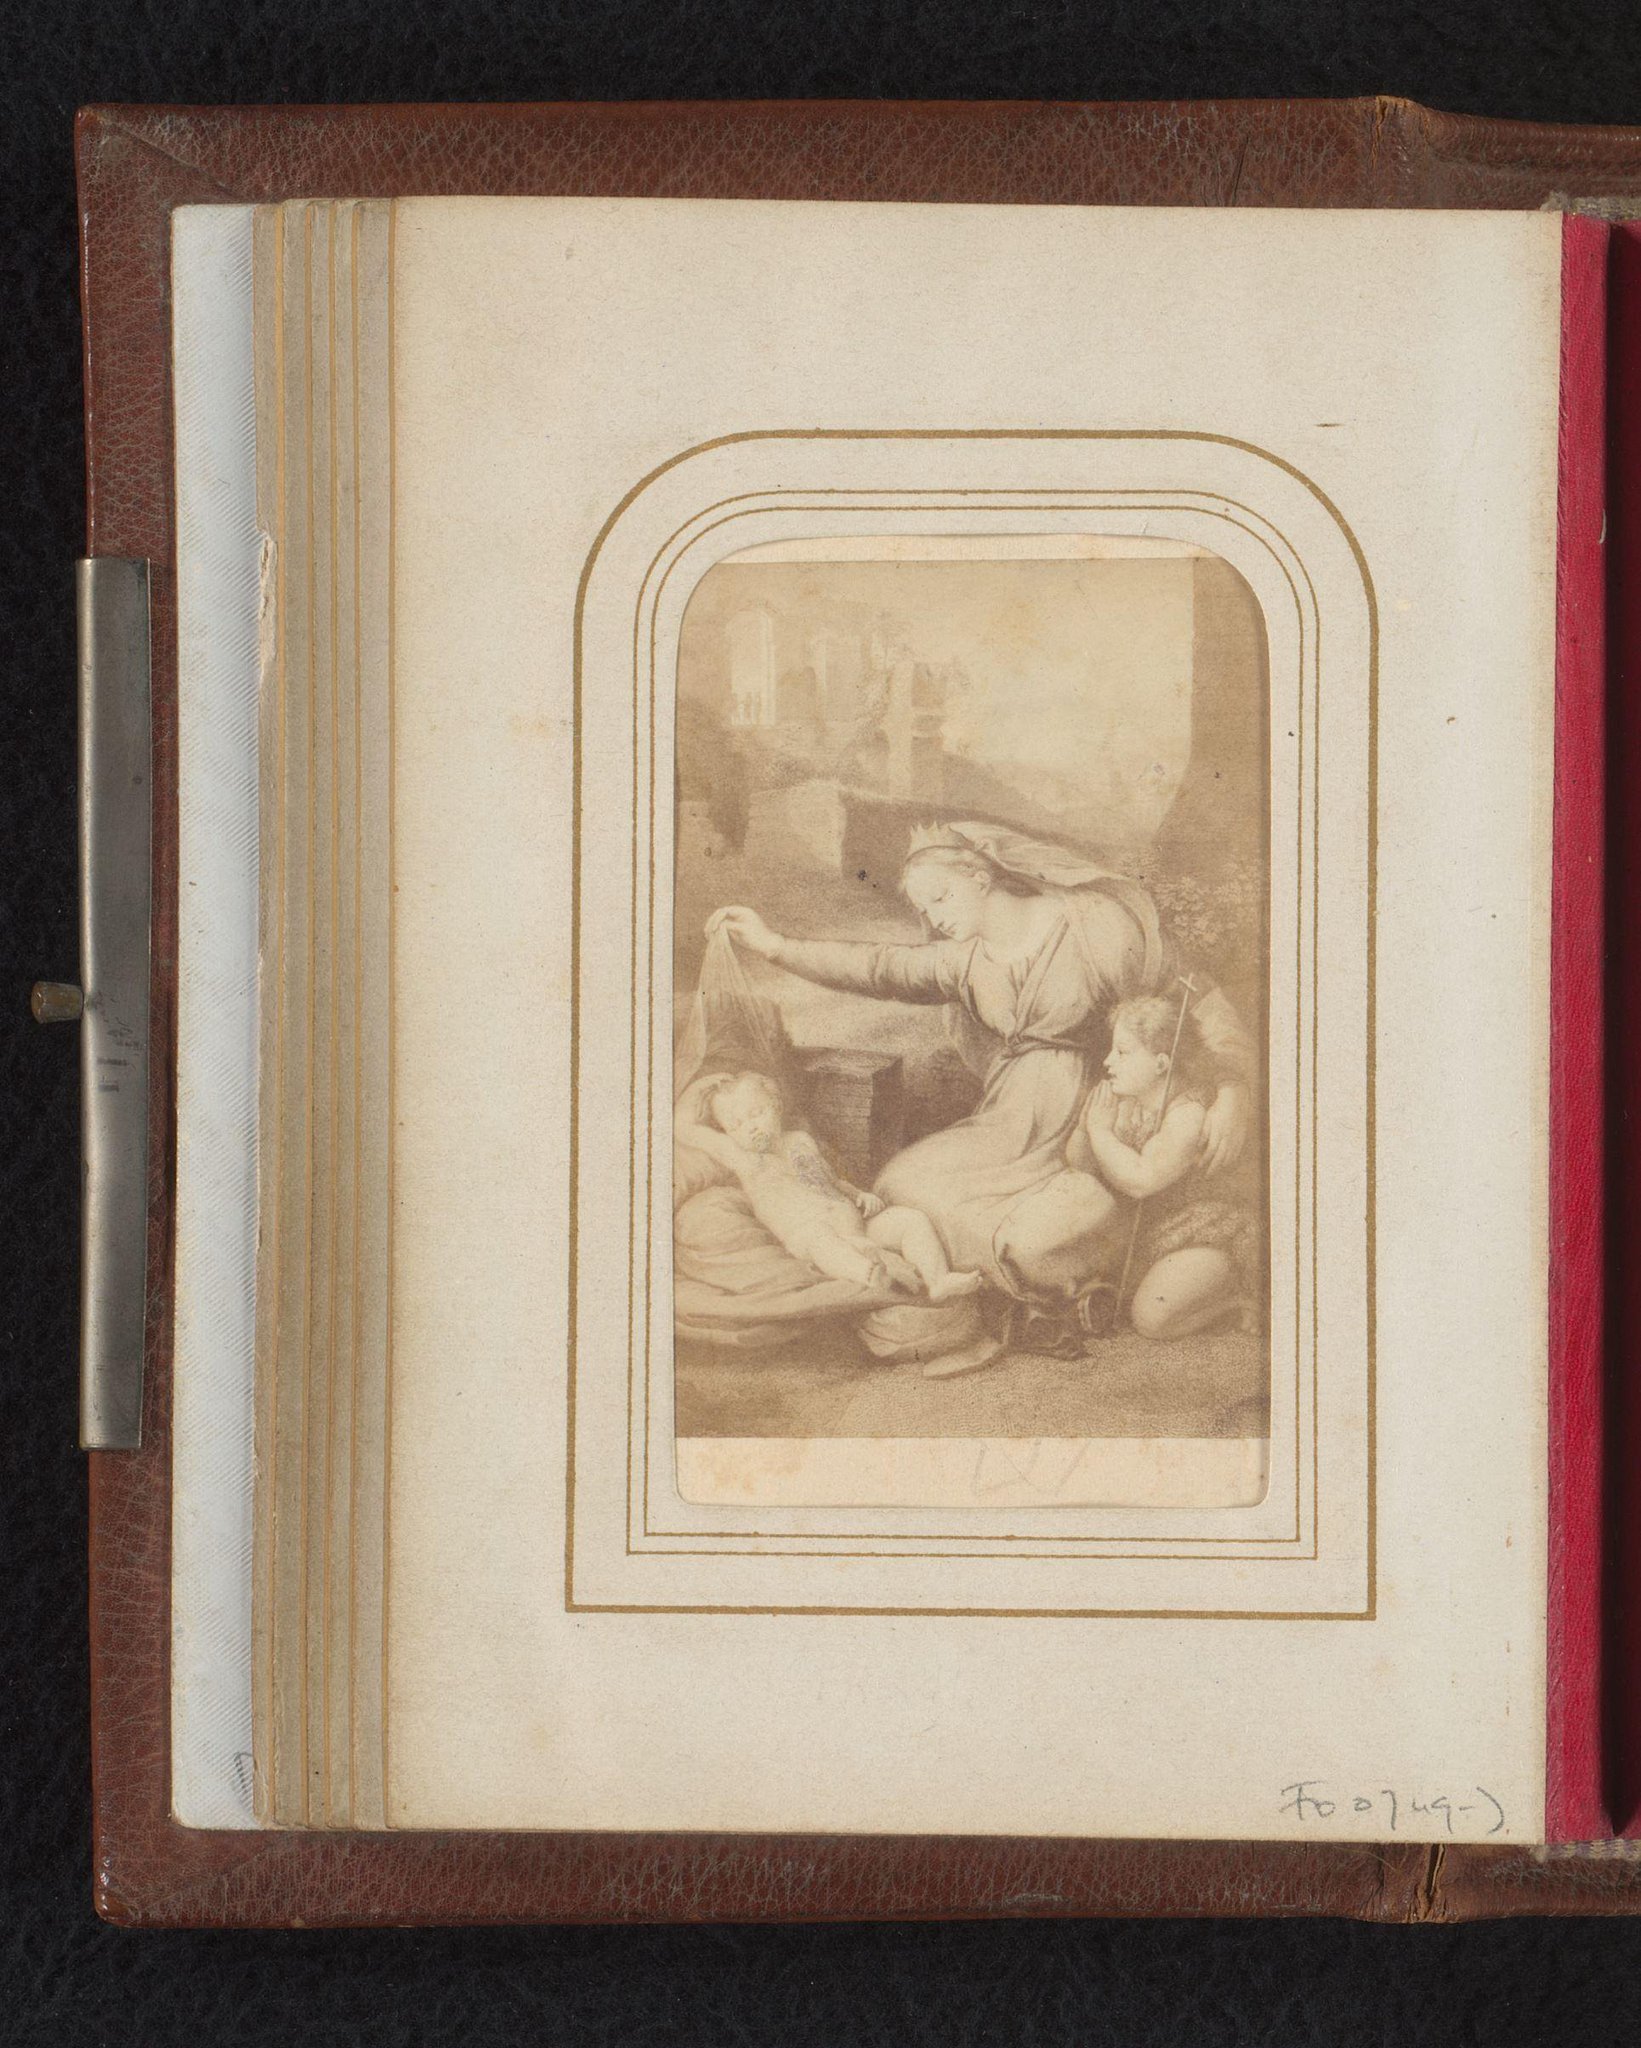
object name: reproduction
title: Fotoreproductie van een prent naar Madonna del Velo door Rafaël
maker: Anonymous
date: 1865-1900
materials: cardboard, photographic support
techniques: albumen print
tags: madonna: i.e. mary with the christ-child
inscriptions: annotation: ‘Madonna del Velo/ Raffaello/ fam. [Orleans]’